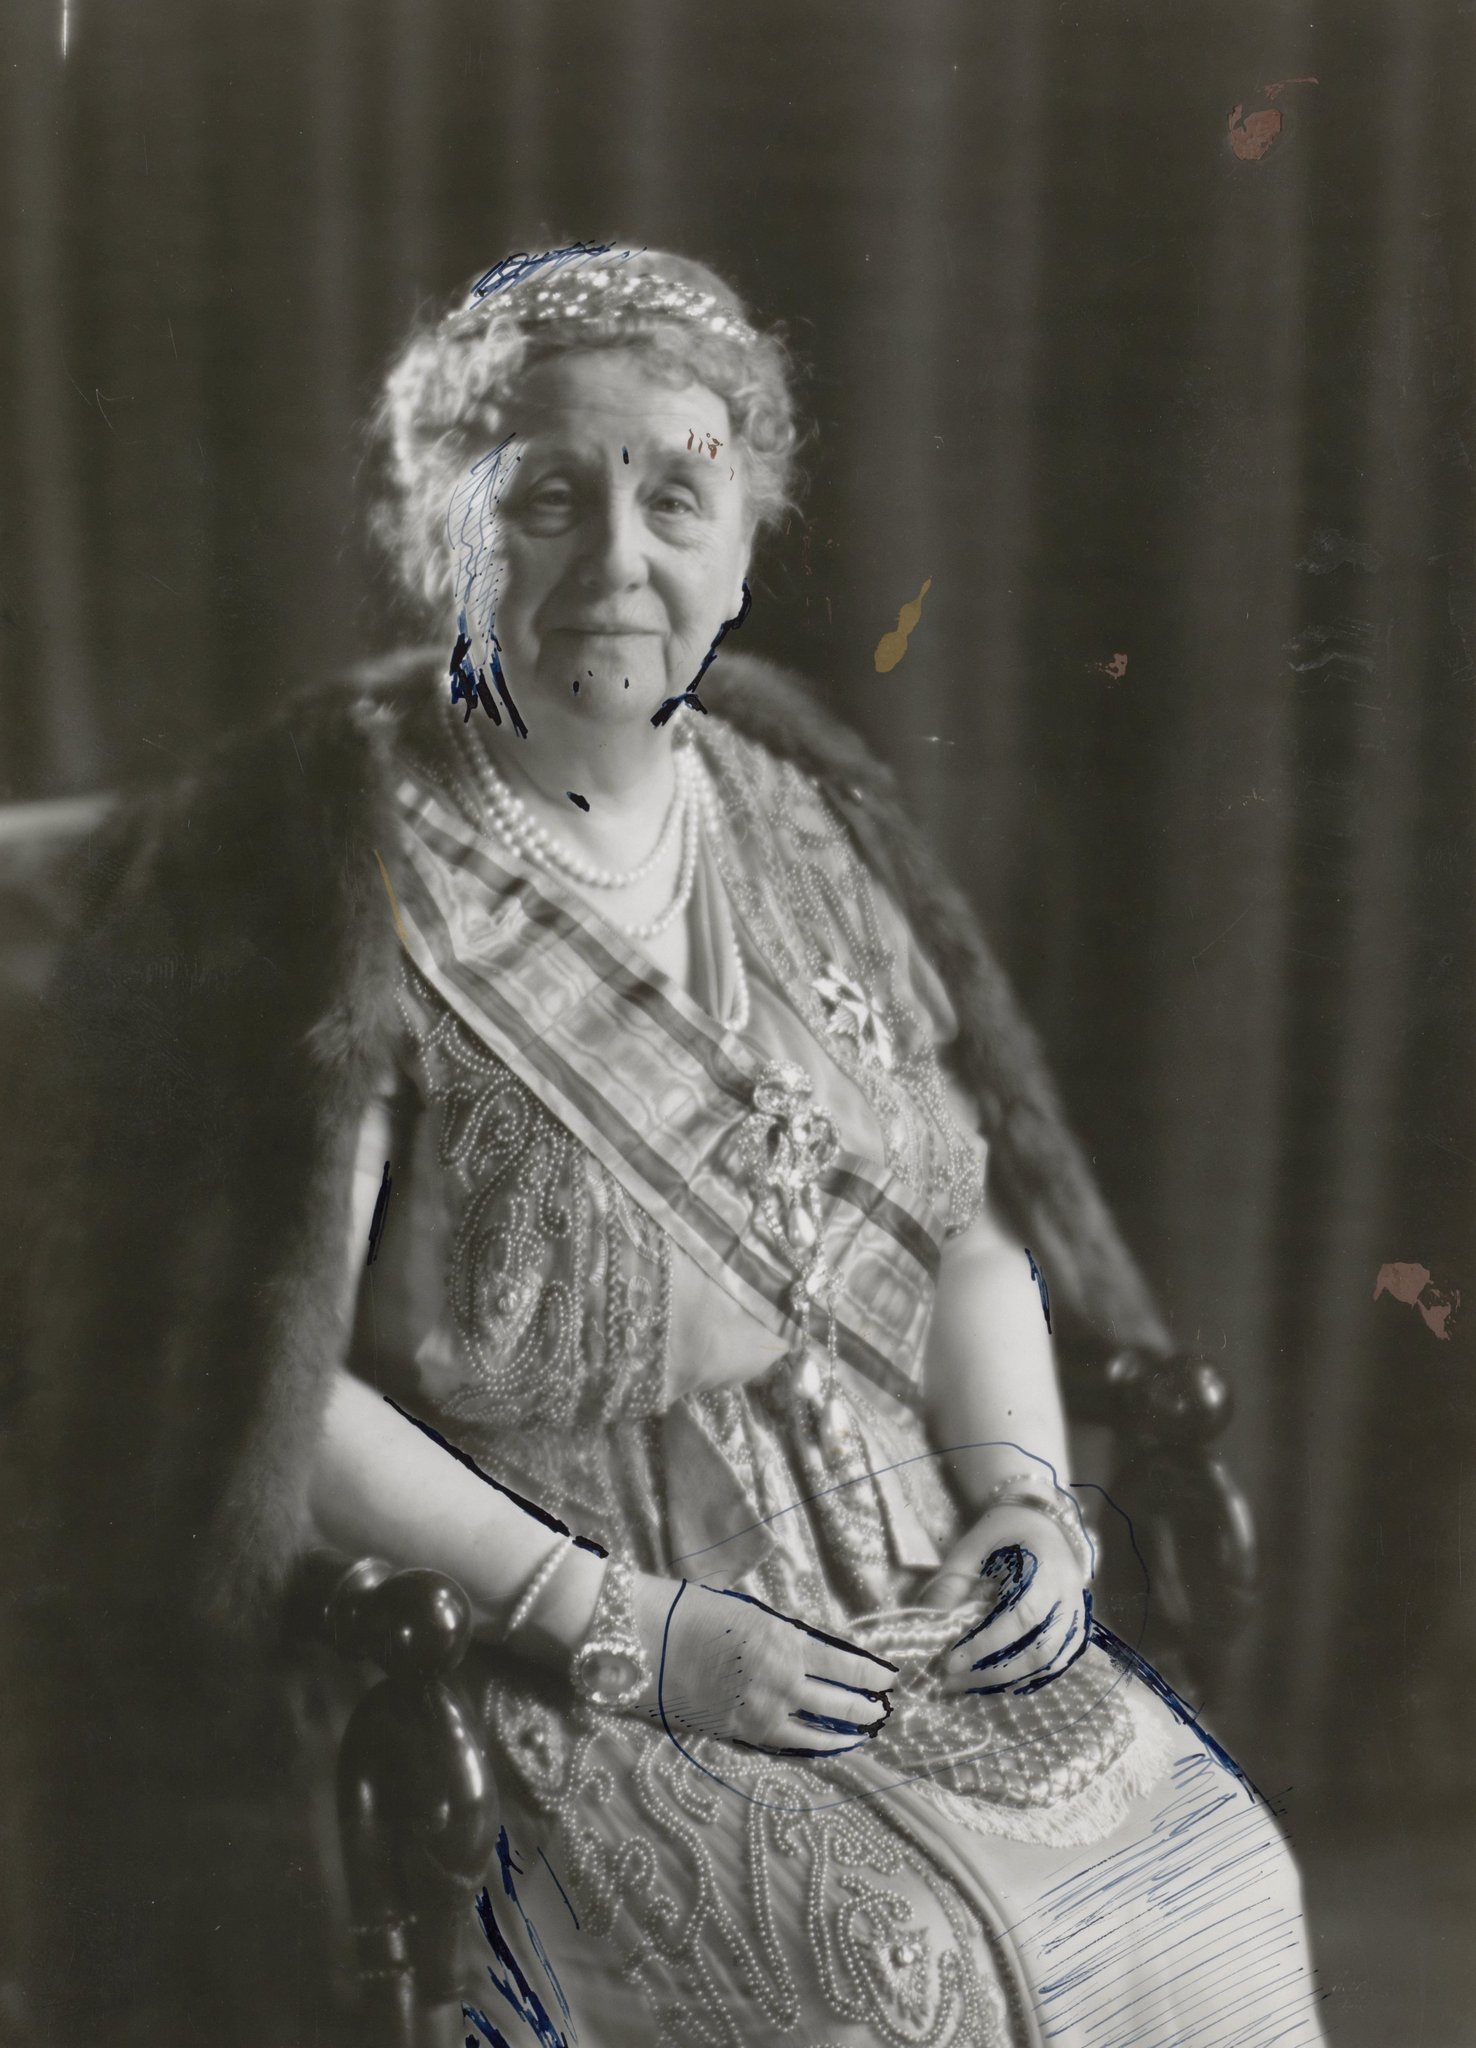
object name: photograph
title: Collectie Merkelbach, portretten van koningin Wilhelmina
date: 1948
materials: photographic support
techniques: gelatin silver print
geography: amsterdam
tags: the hague, print maker, wilhelmina of the netherlands, amsterdam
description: Koningin Wilhelmina poseert met de Willemsorde. Portret staand, ten voeten uit.